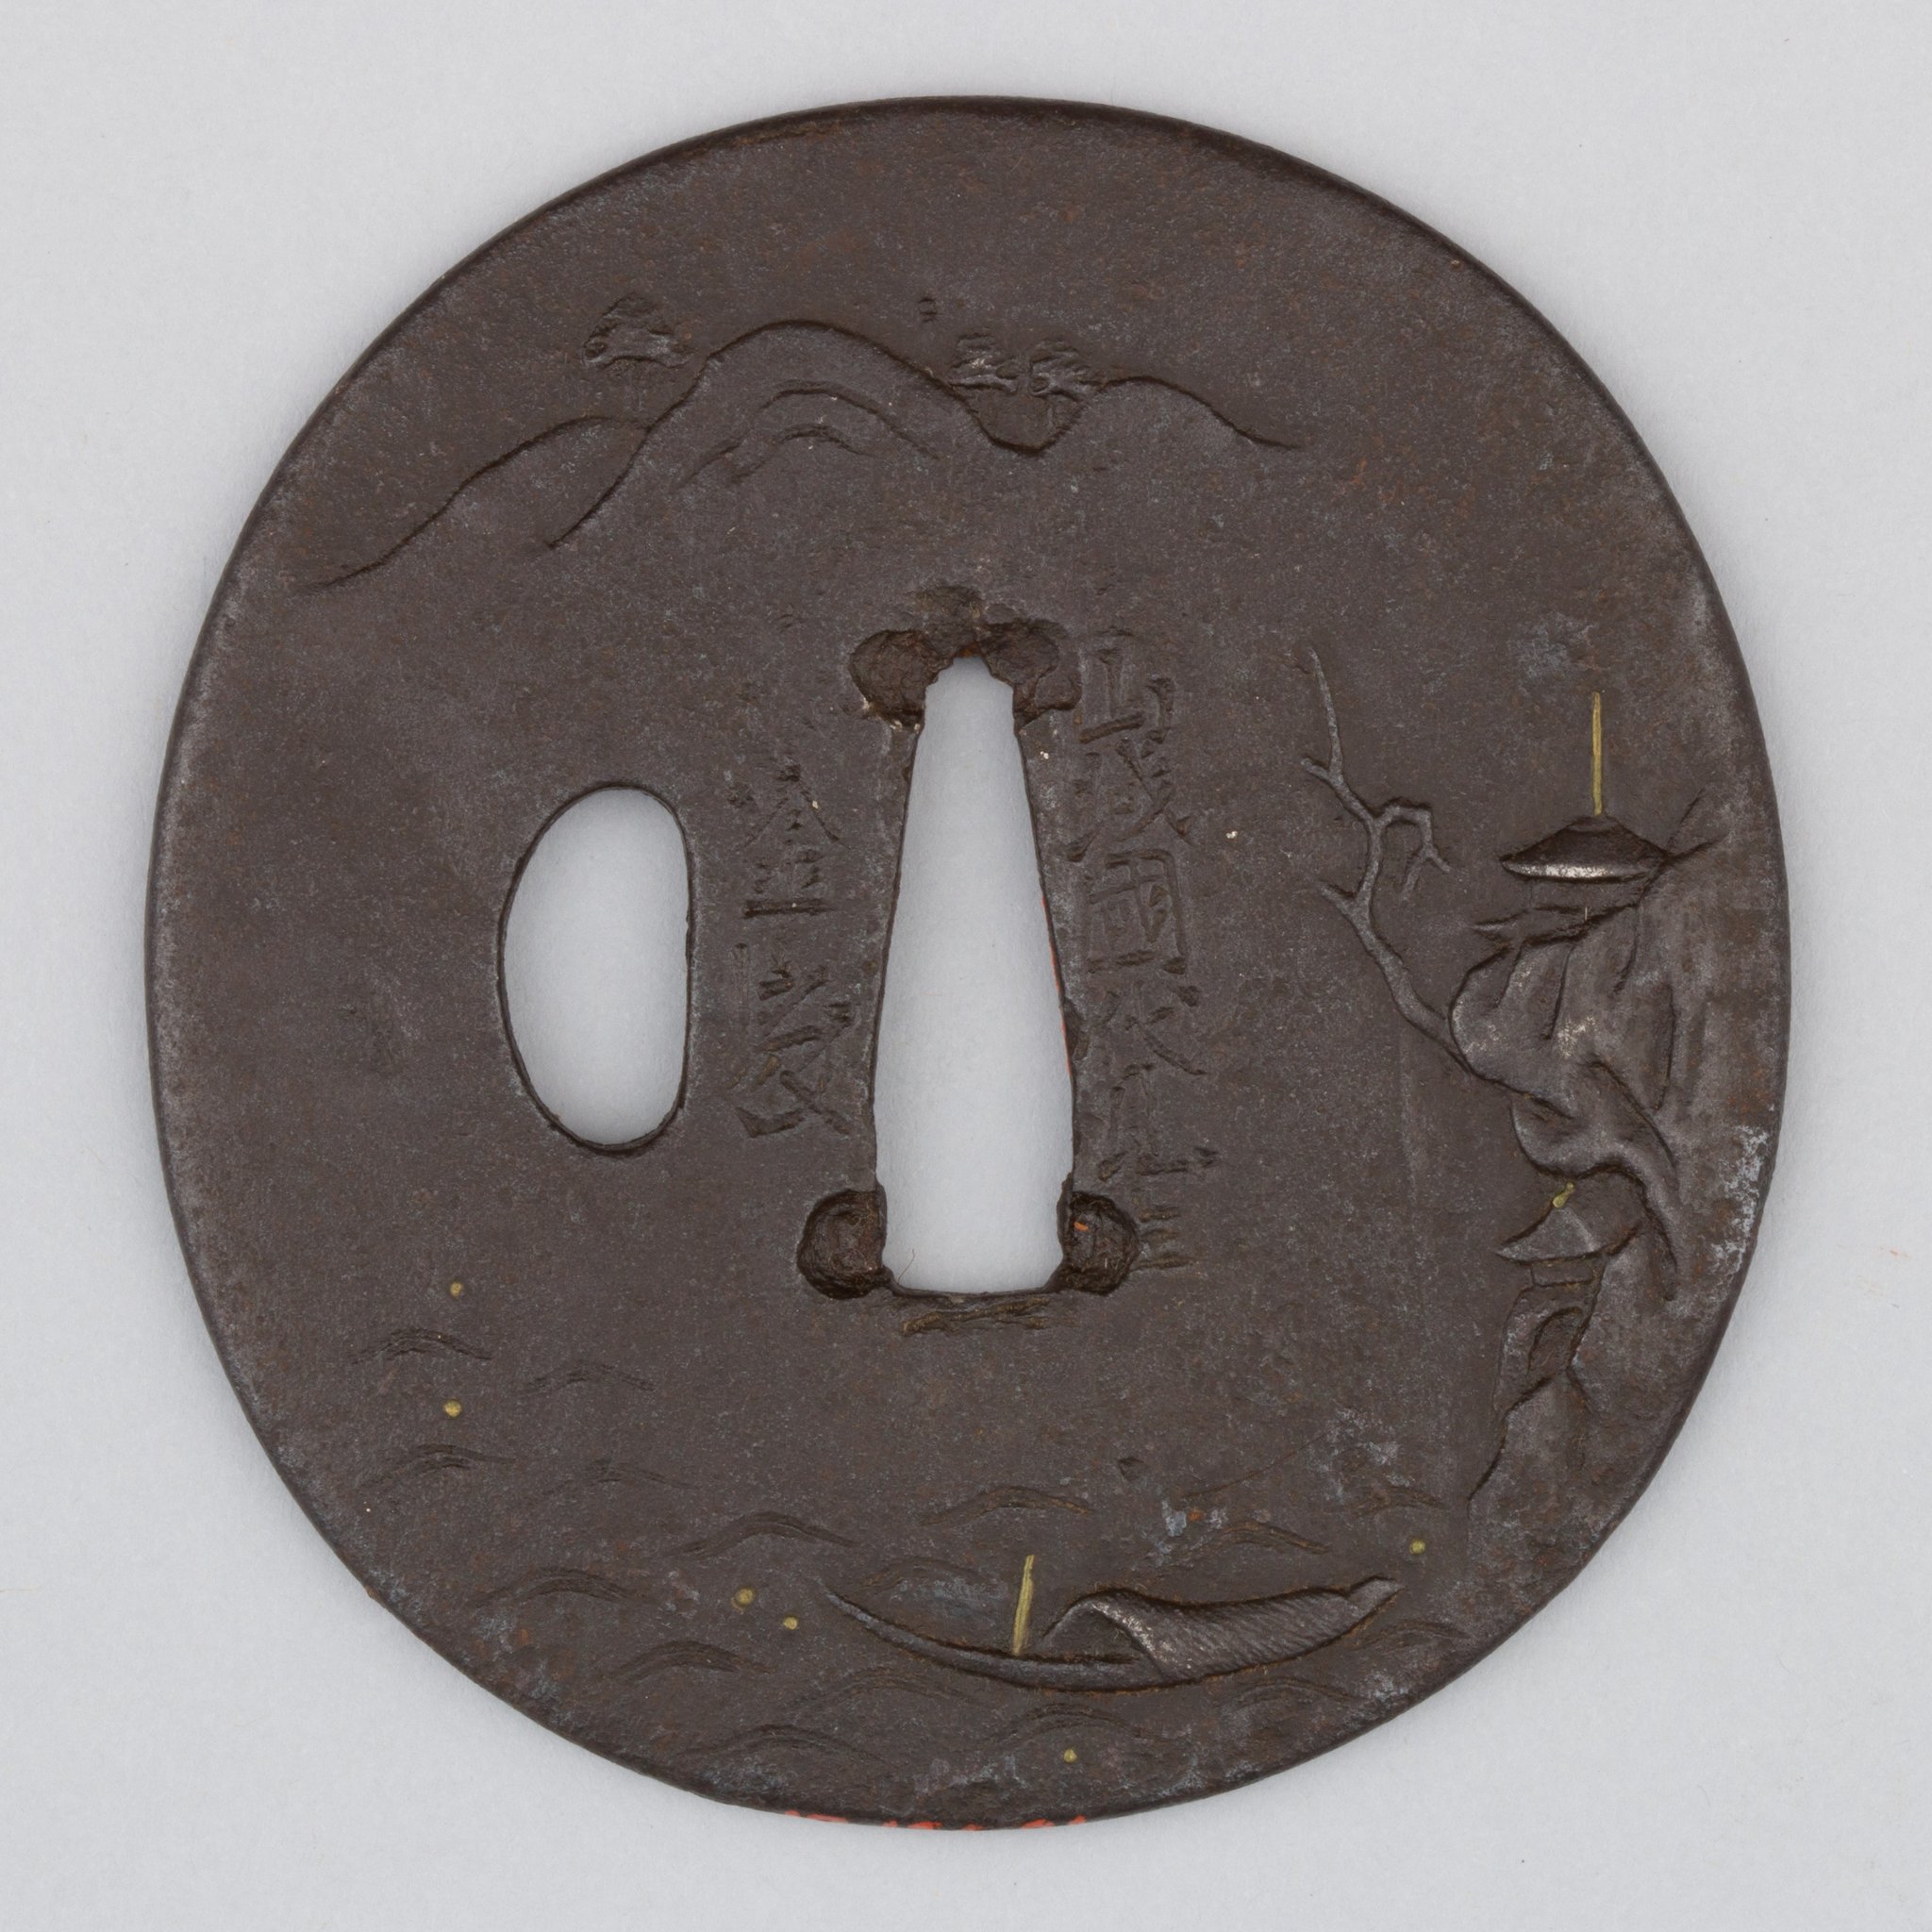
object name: sword guard tsuba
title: Sword Guard (Tsuba)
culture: japanese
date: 1701-1800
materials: copper, iron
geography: japan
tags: boats